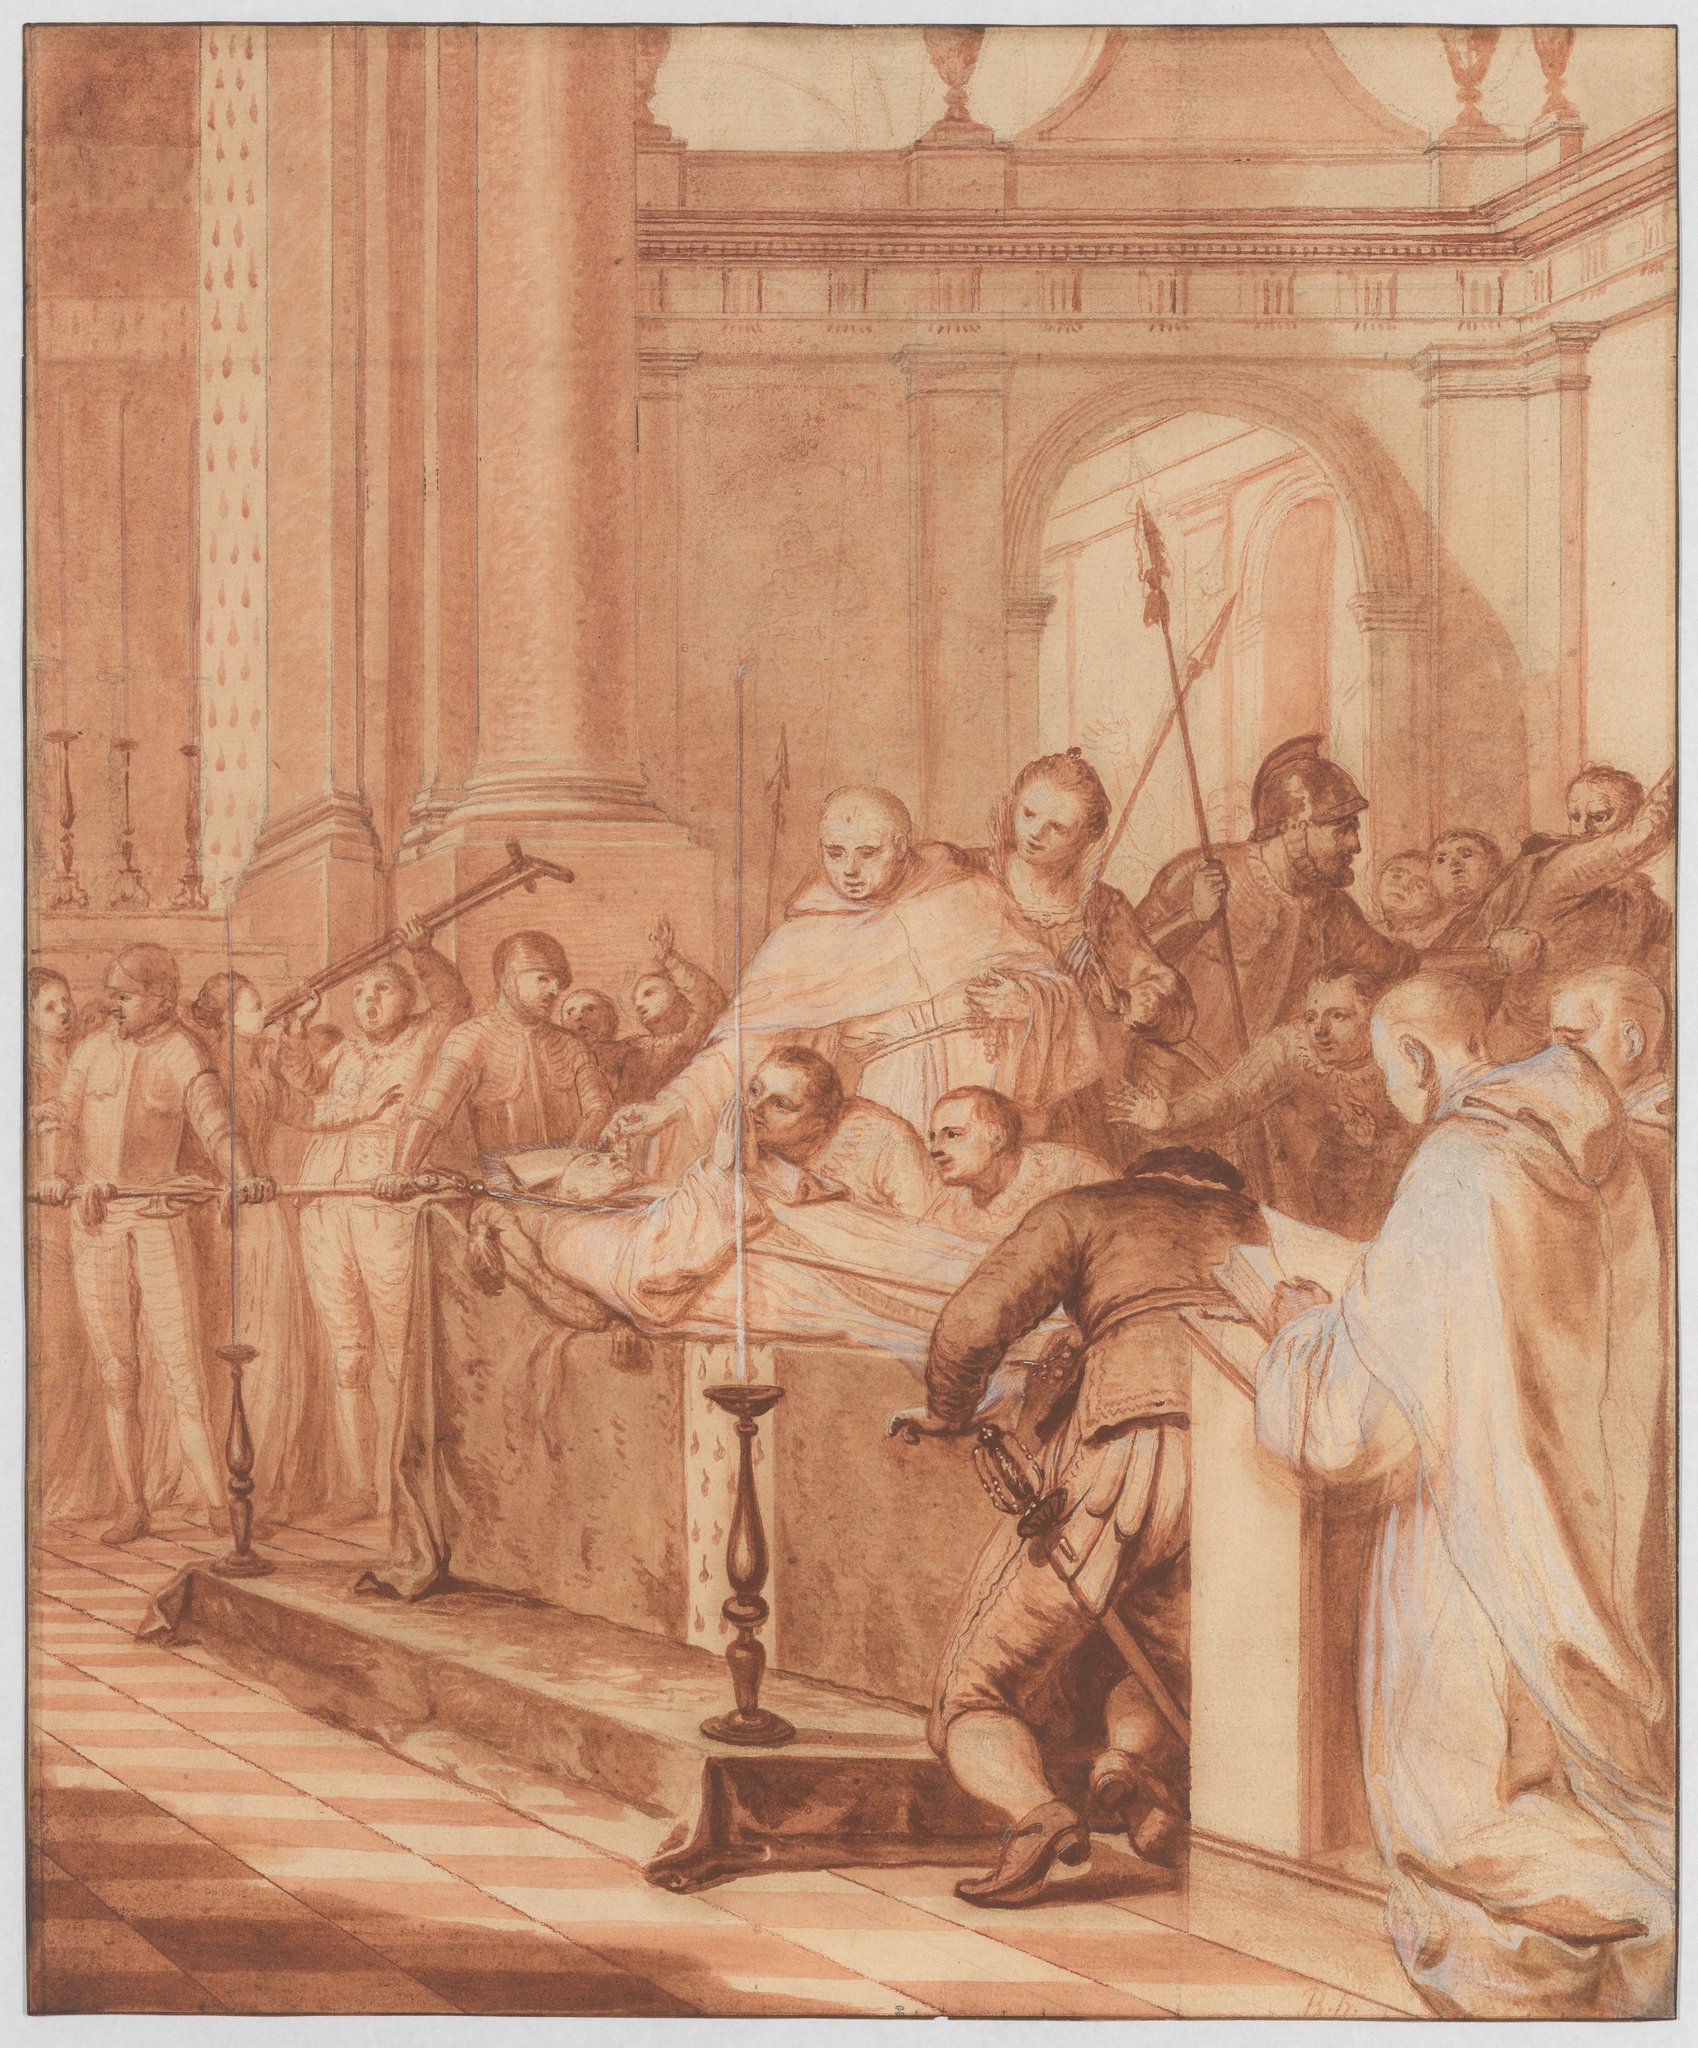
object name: drawing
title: Scene 34: To satisfy the devotion of the people, they are forced to leave the Blessed Abbot's body on display for three days; many miracles are performed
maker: matthieu elias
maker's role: artist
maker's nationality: french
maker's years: 1658-1741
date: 1706-1707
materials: chalk, graphite, ink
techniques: brush, heightening, pen, wash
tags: soldiers,men,women